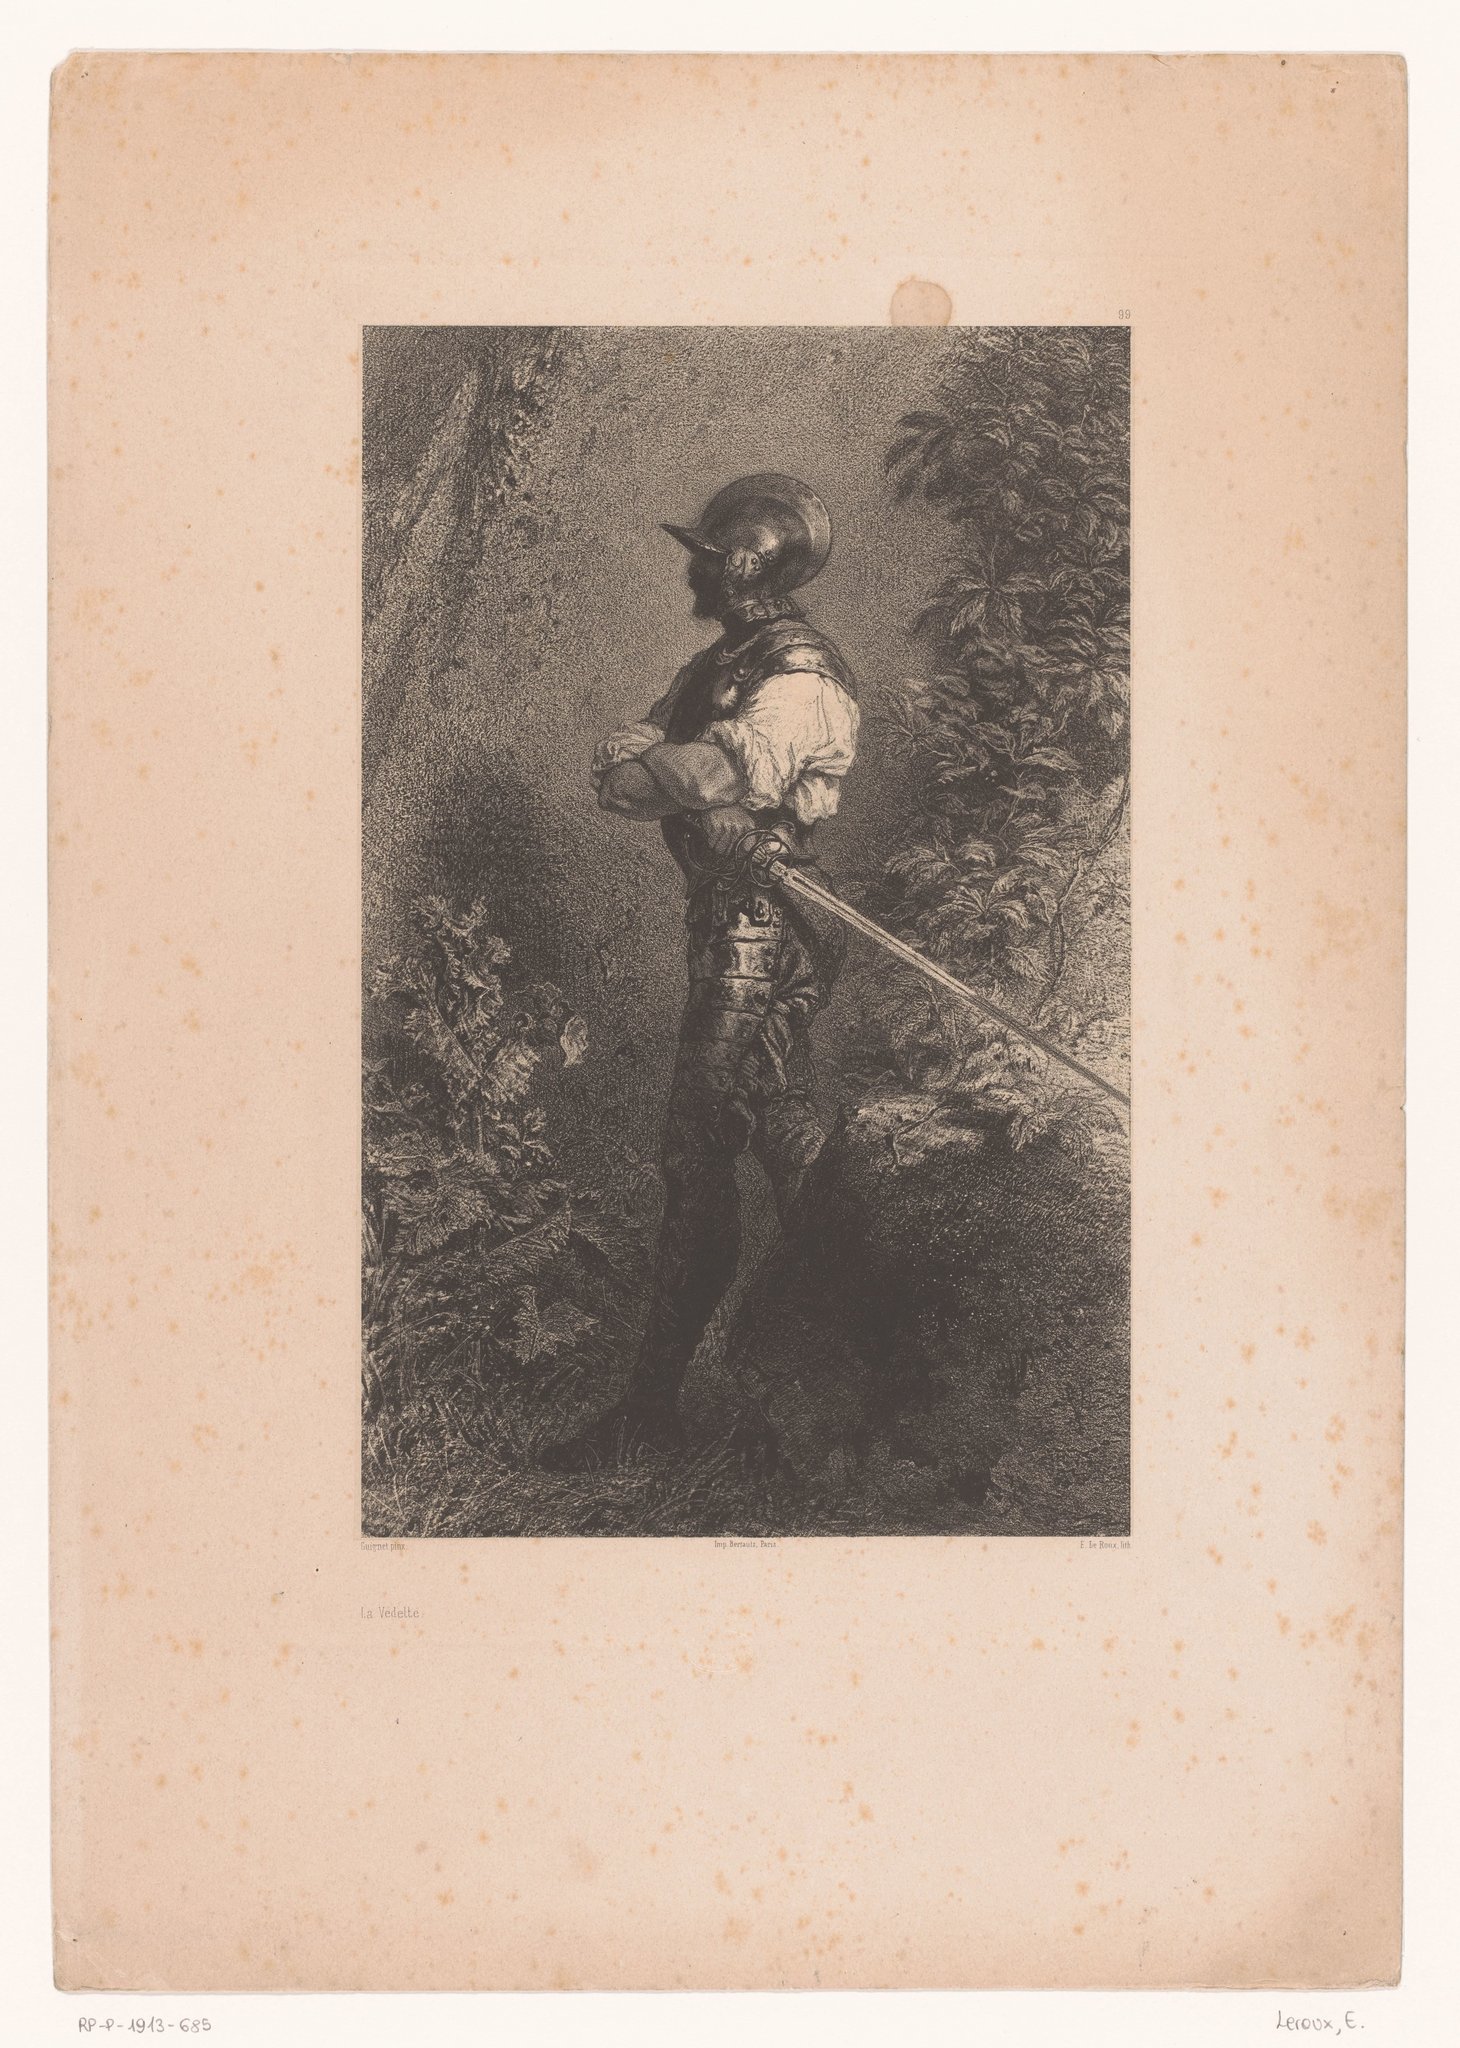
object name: print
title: La Vedette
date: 1853-1854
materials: paper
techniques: lithography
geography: paris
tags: helmet, private soldier, guard duty, keeping sentry, hacking and thrusting weapons: rapier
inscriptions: collector's mark: Lugt 2233, check stamp: Lugt 36a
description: Prent gebruikt voor: Les Artistes anciens et modernes, dl. 3, vol. 5, 1853-1854.